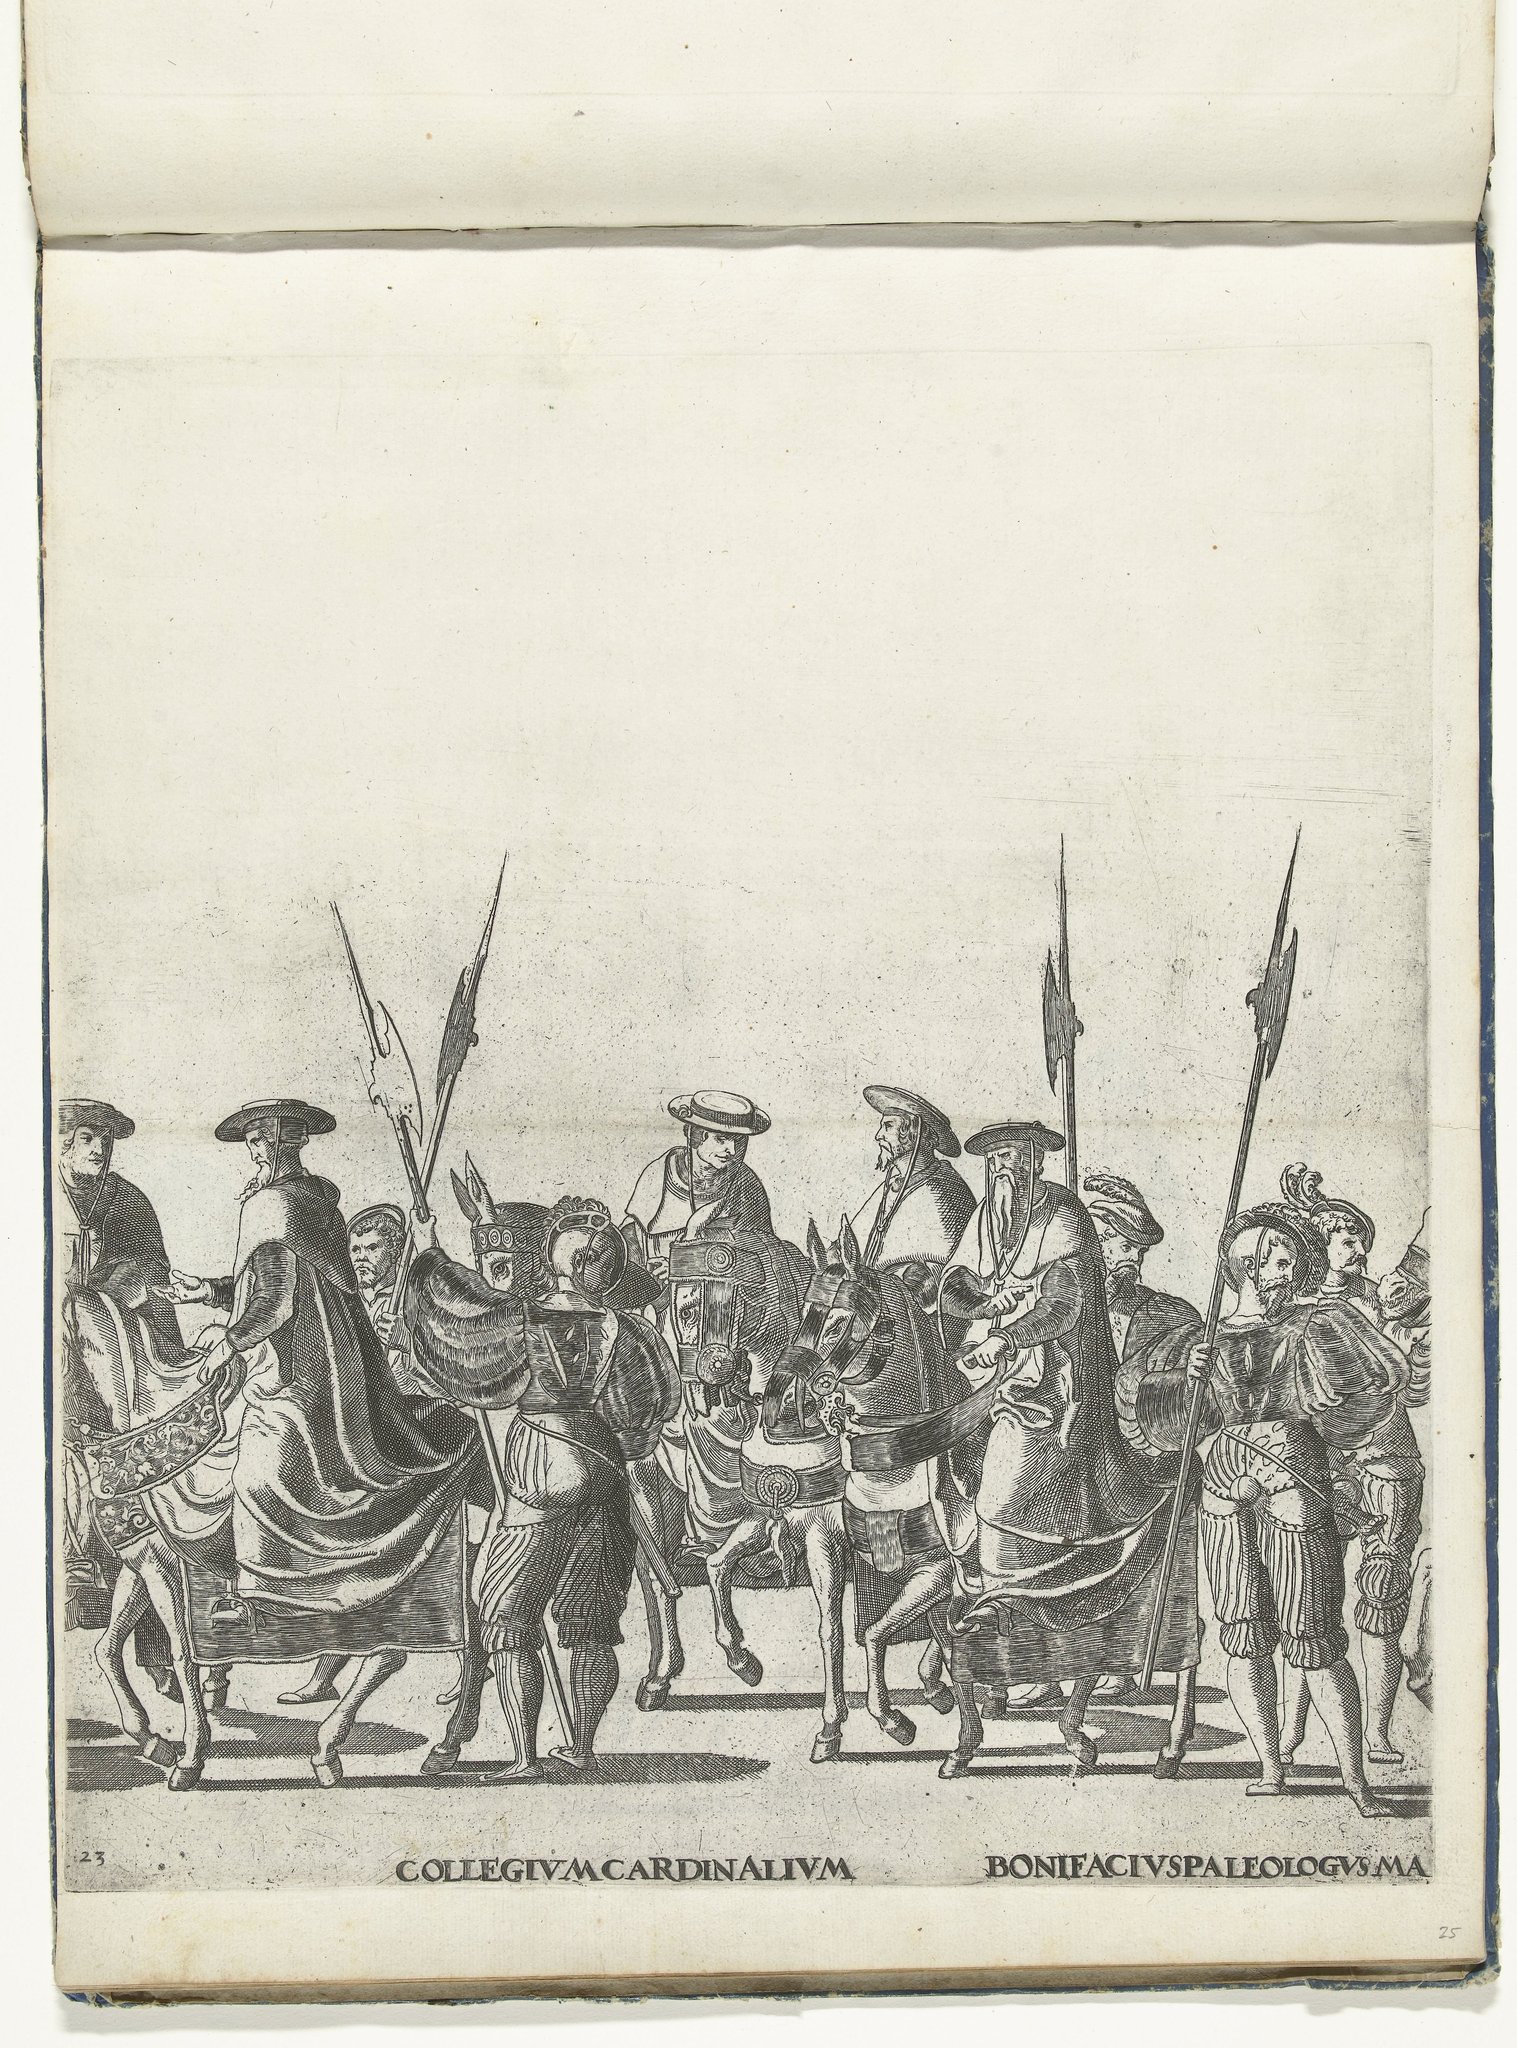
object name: propagandaprent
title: Optocht van Karel V met de paus te Bologna na zijn kroning to keizer, 1530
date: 1530-1536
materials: paper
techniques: engraving, etching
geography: the hague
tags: ghent, charles v (holy roman emperor and king of spain), rome, festivities (+ parade, pageant, cavalcade ~ festive activities)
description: Prent in het album waarin zijn ingeplakt de 40 platen die achterelkaar samen het fries vormen van de optocht van Karel V met de paus Clemens VII te Bologna na zijn kroning tot keizer, 24 februari 1530.